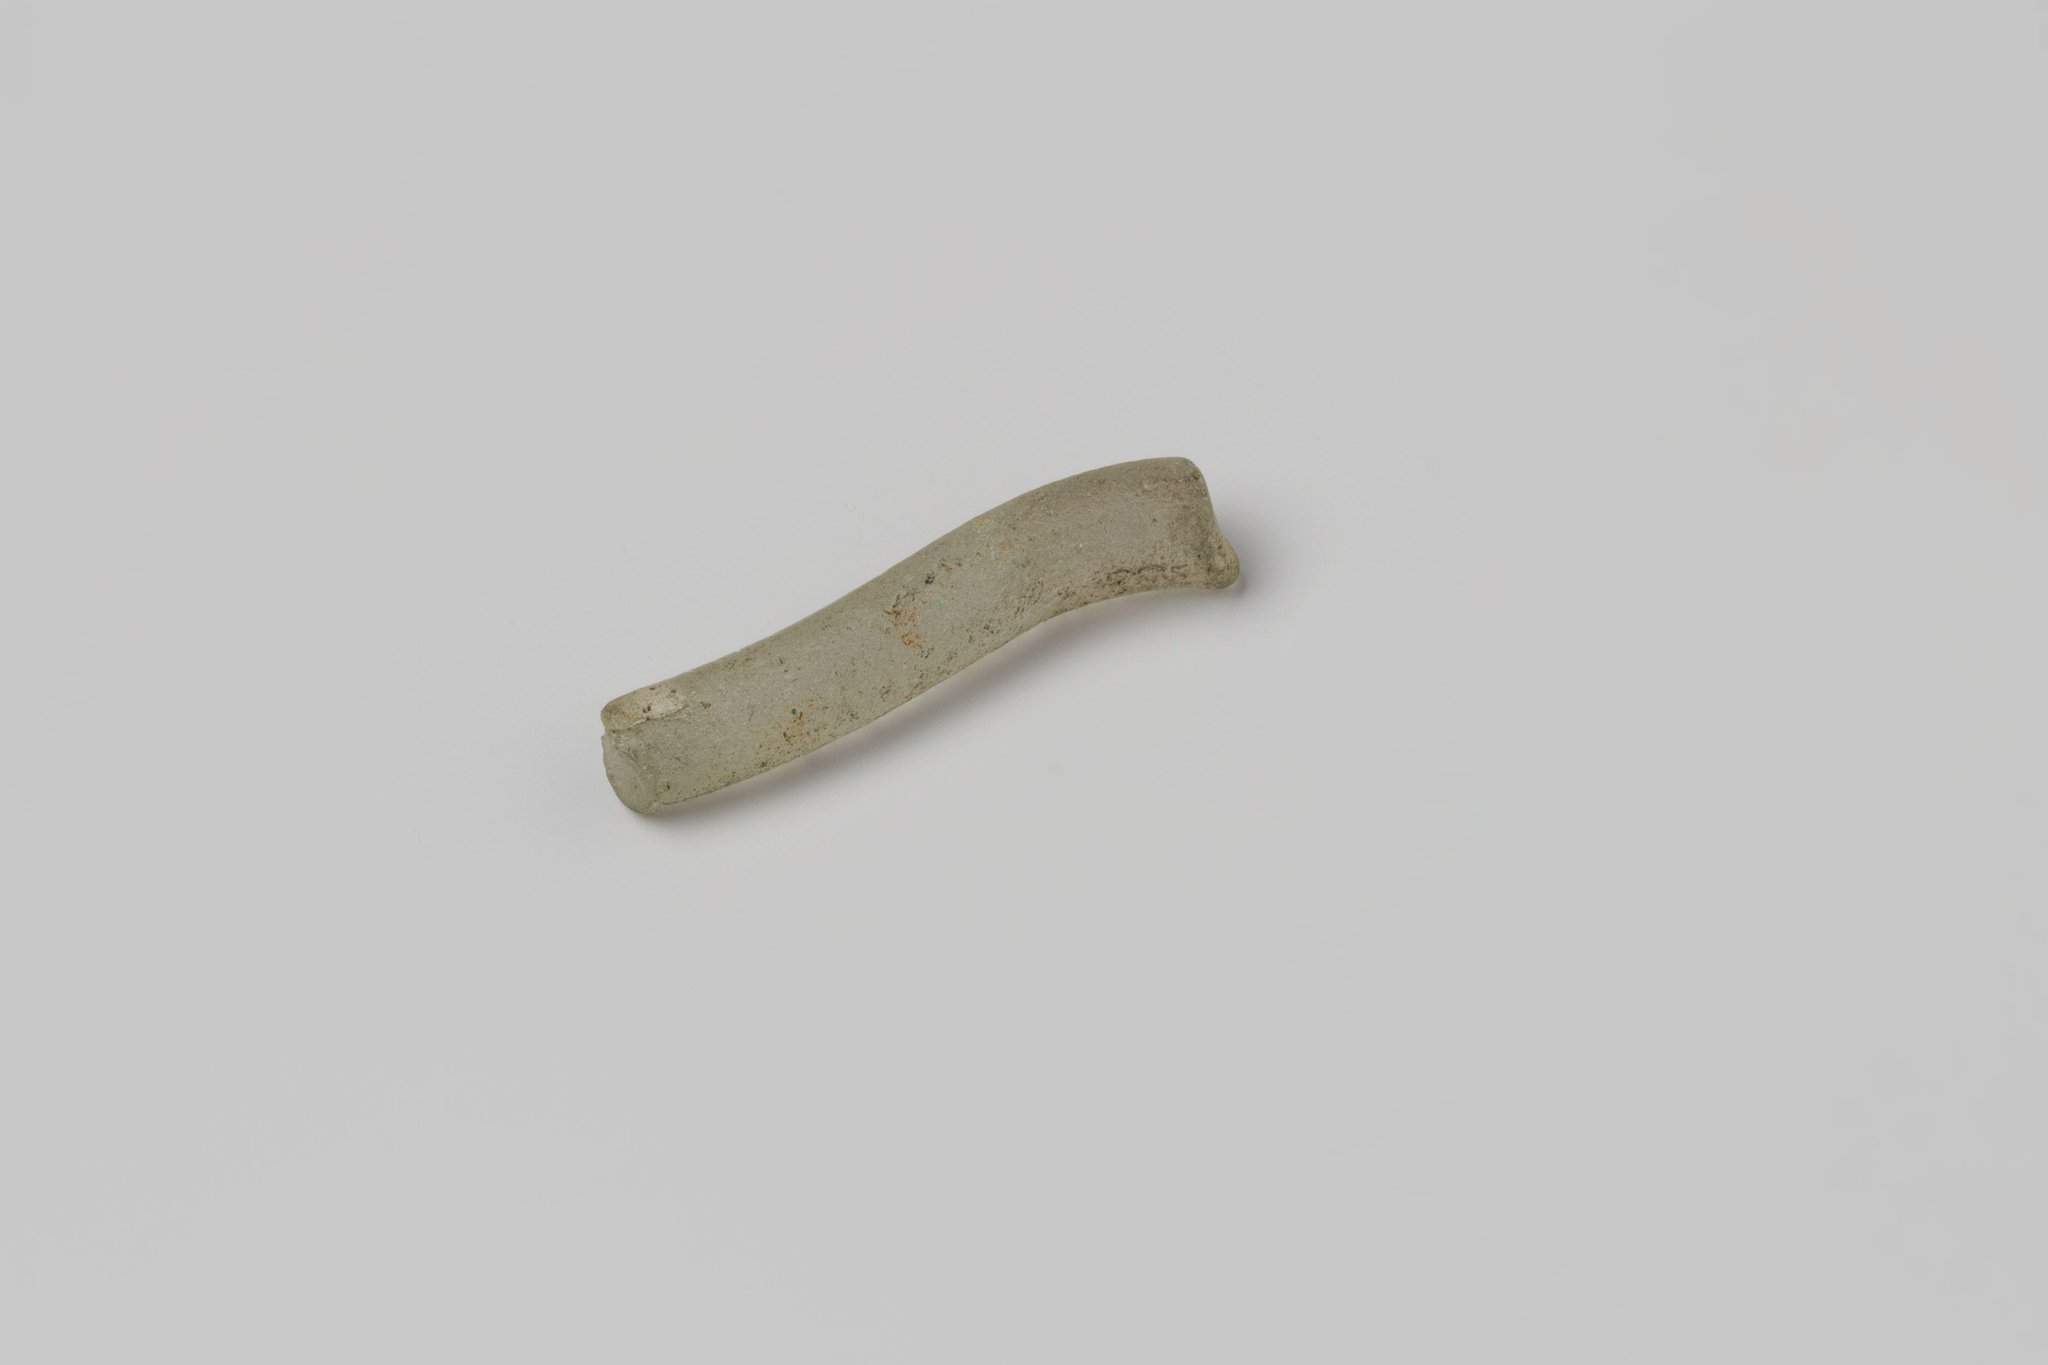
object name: vessel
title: Fragment handvat van vaatwerk uit het wrak van de Oost-Indiëvaarder Hollandia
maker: Anonymous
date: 1700-1743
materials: glass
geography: netherlands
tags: verenigde oostindische compagnie, hollandia (schip), annet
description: Vessel part, handle; fragm, sim. NG 1980-27H1299.